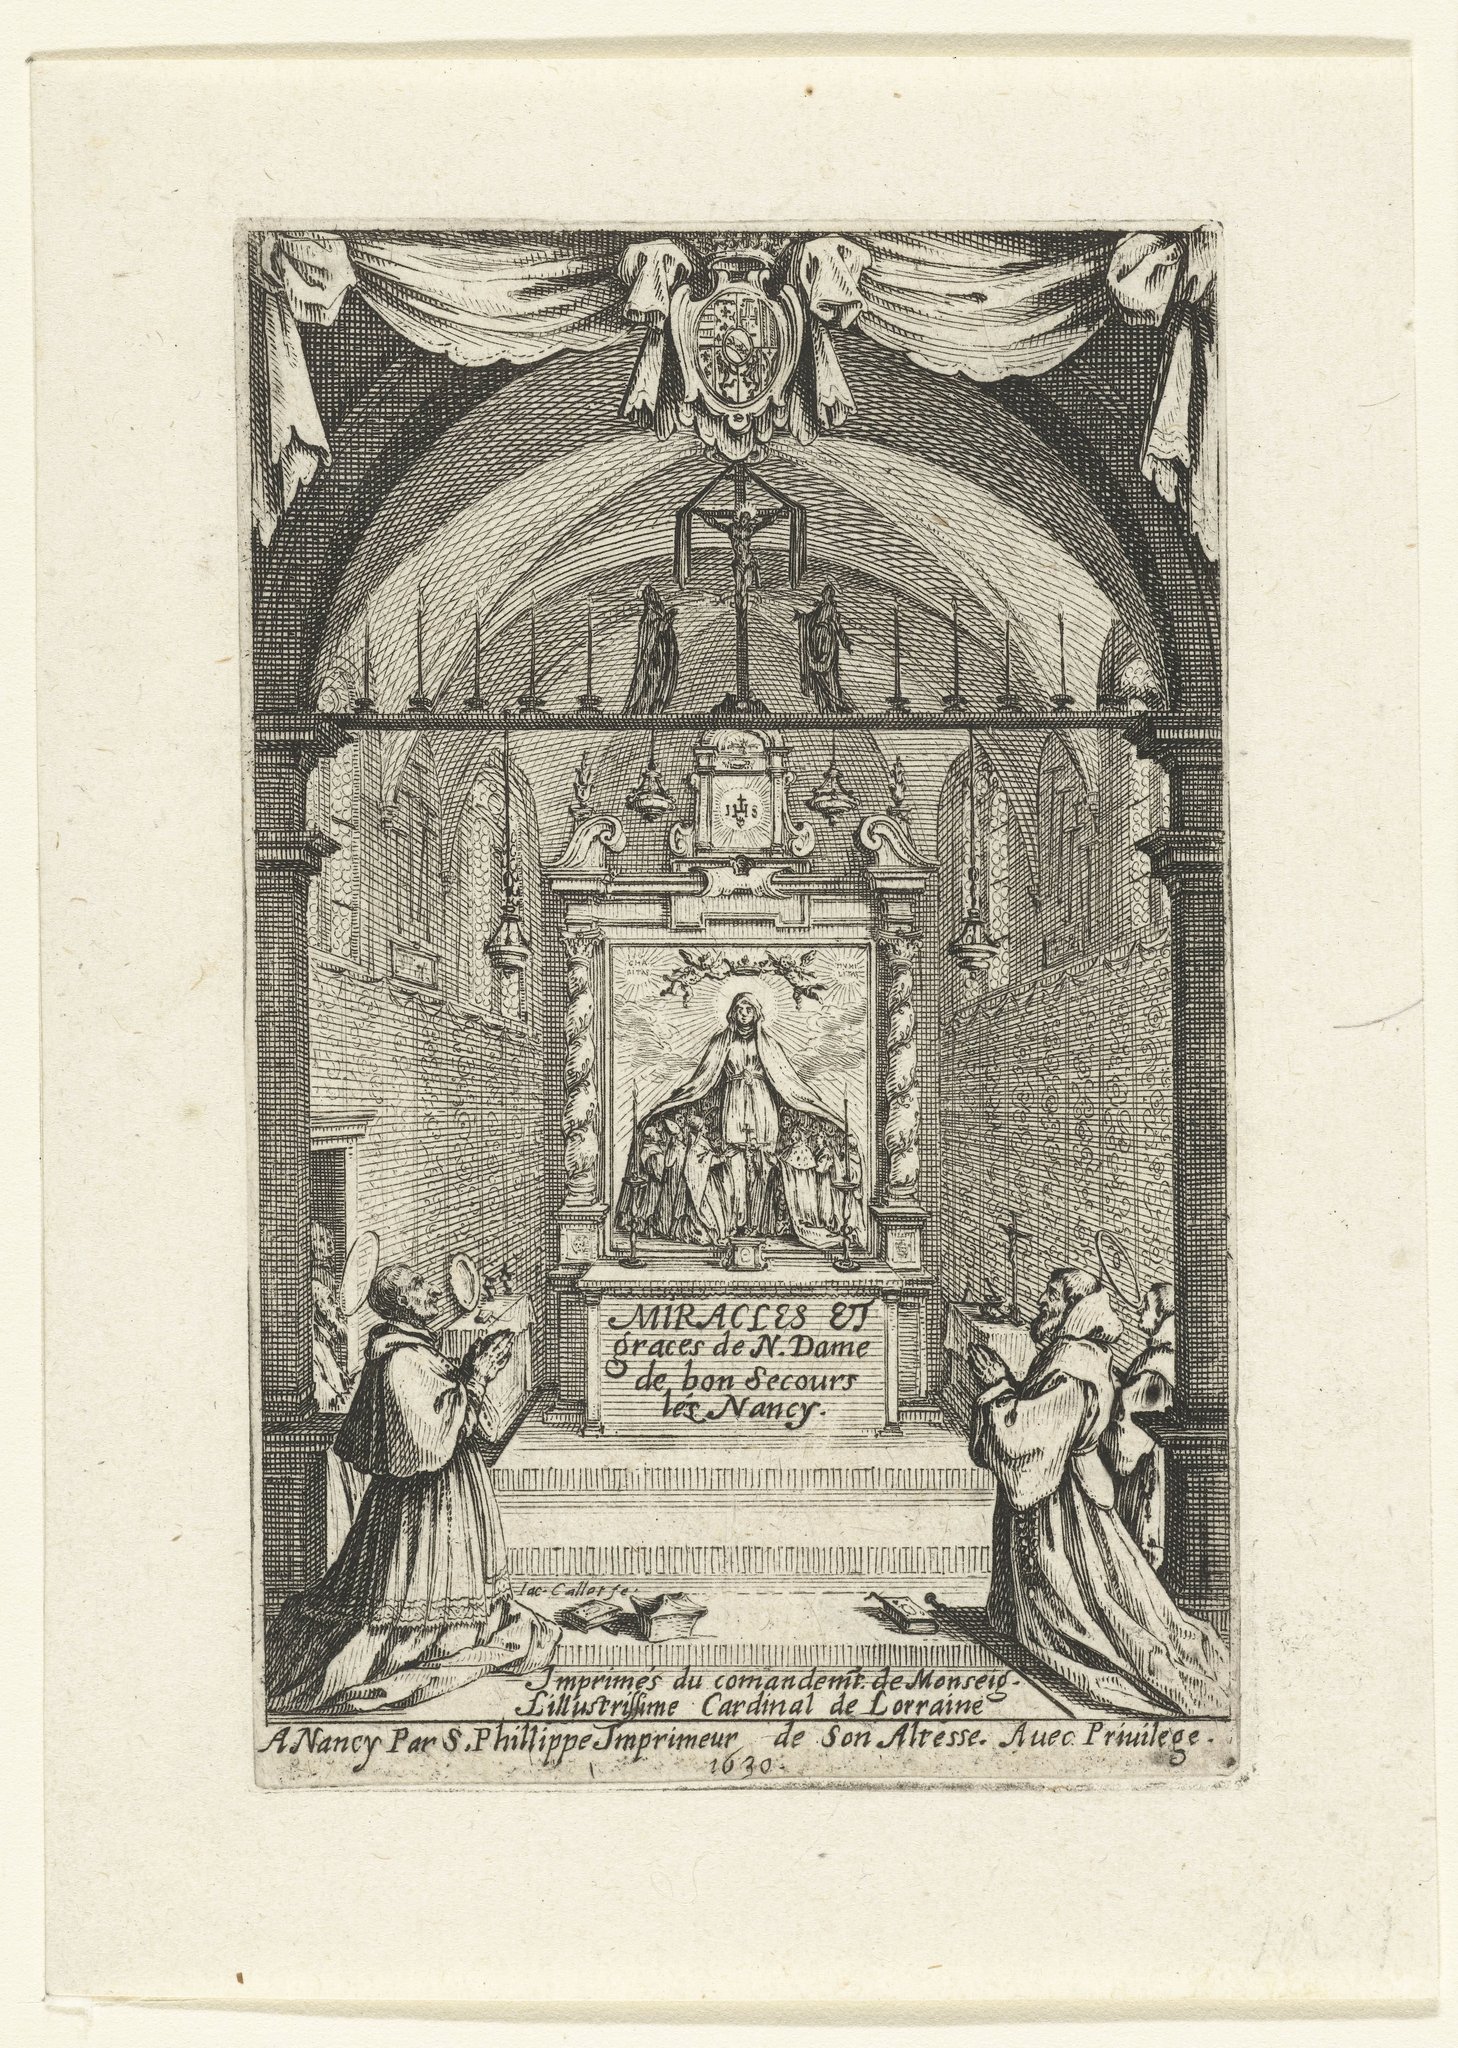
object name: print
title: Miracles et graces de N. Dame de bon Secours lés Nancy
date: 1630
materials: paper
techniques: etching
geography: nancy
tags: title-page, the hermit and founder of the (franciscan) minim friars, francis of paola; possible attributes: inscription 'charitas' on breast, discipline, skull, staff, mother of mercy, 'mater misericordiae', 'schutzmantelmadonna', 'schutzmantelmaria', charles borromeo, cardinal of milan; possible attributes: cardinal's hat, crucifix, rope round his neck, skull, armorial bearing, heraldry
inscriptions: collector's mark: Lugt 240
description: Twee heiligen (Franciscus van Paula rechts en Carolus Borromeüs links) knielen in een kerk voor een altaar met een Franse tekst en een voorstelling van een Mantelmadonna. Aan het plafond een wapenschild.